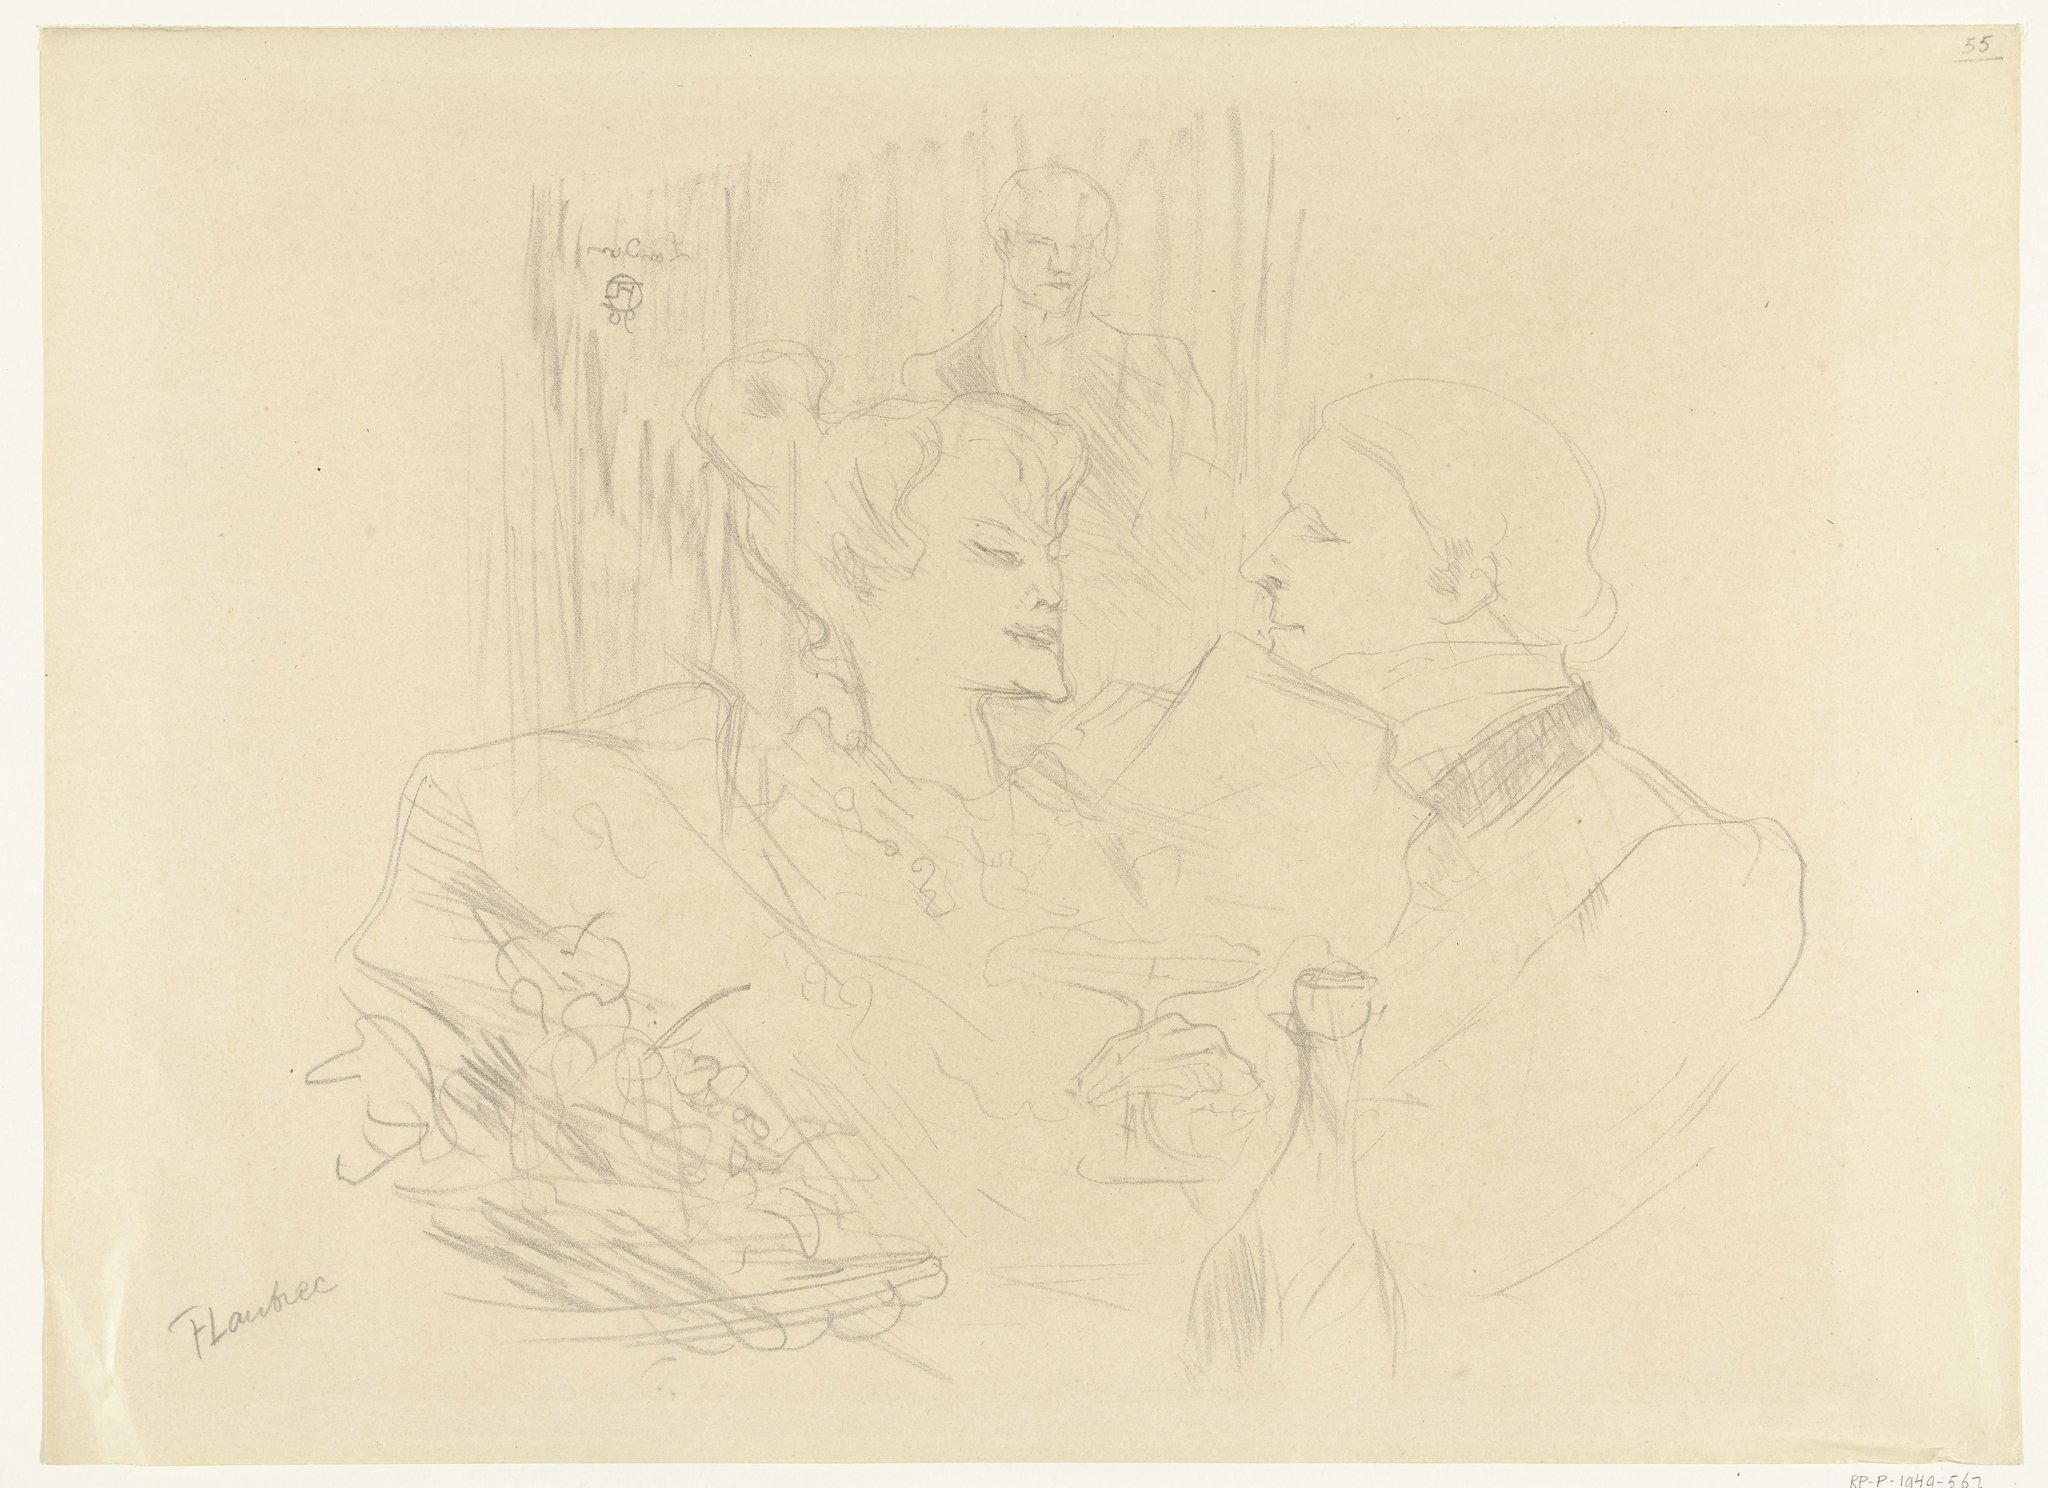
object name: print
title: Portret van kunstenaar Charles Conder tijdens diner met een vrouw in Londen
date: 1896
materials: paper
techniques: lithograph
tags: artist, charles conder, portrait, self-portrait of painter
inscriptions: collector's mark: Lugt 2228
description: Verschenen in een oplage van honderd exemplaren in de serie Etudes de femmes op initiatief van Le livre vert, L'Estampe originale, André Marty (uitgever), 1896